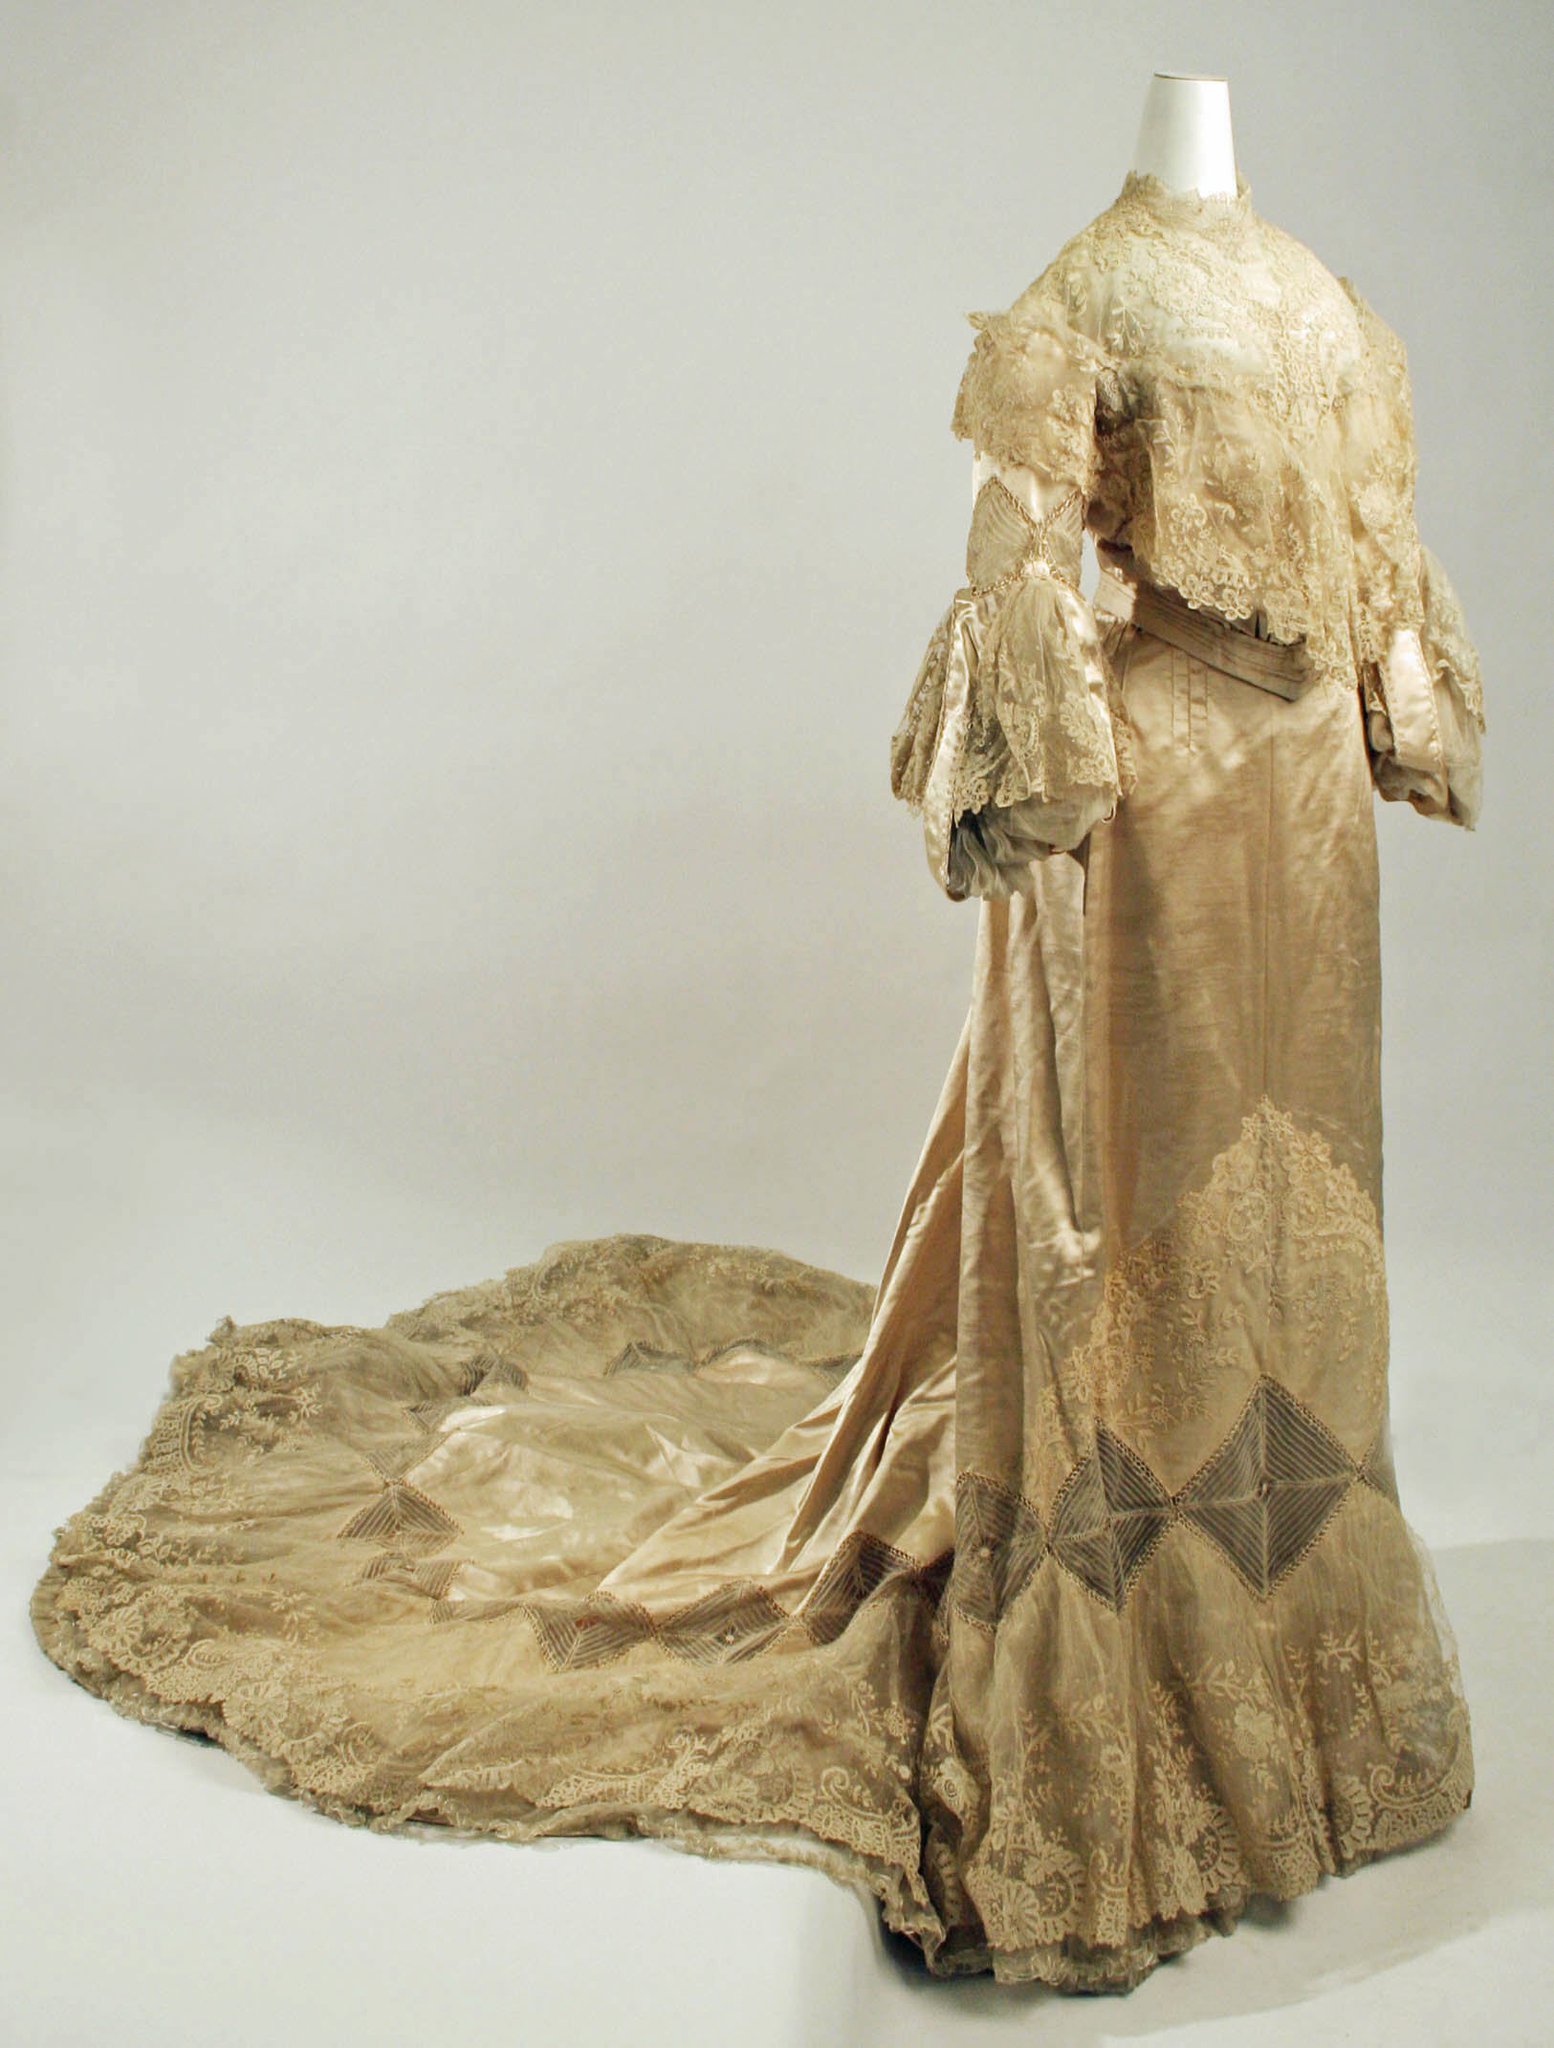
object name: wedding ensemble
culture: american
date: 1902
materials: cotton, silk